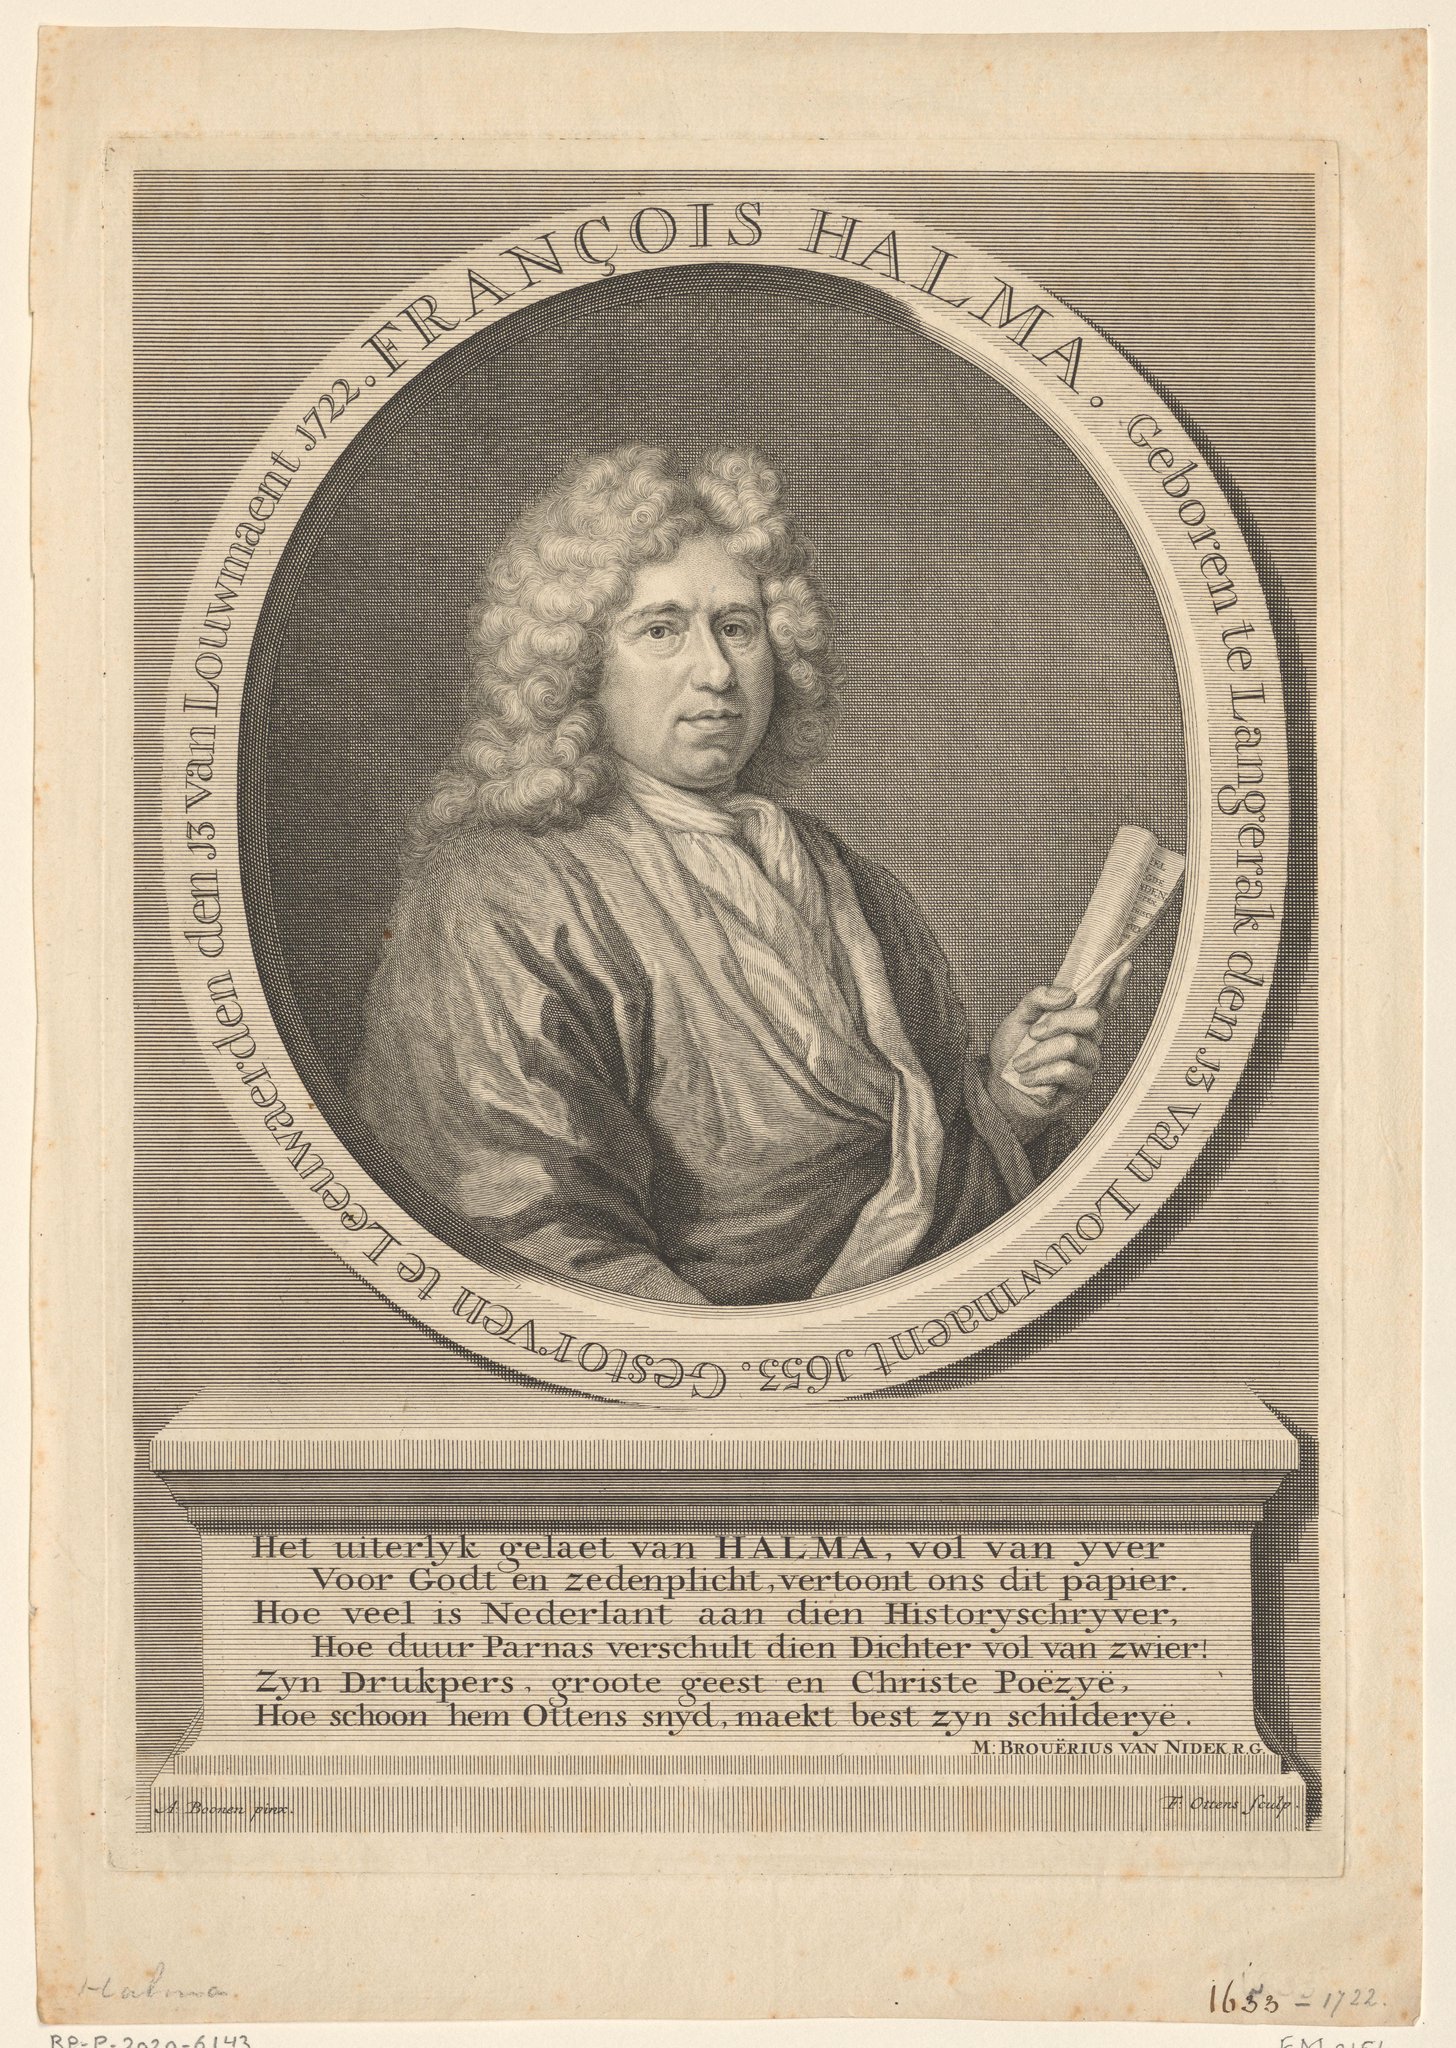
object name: print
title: Portret van François Halma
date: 1722-1770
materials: paper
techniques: engraving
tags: françois halma, historical persons, writer, poet, author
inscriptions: collector's mark: Lugt 964